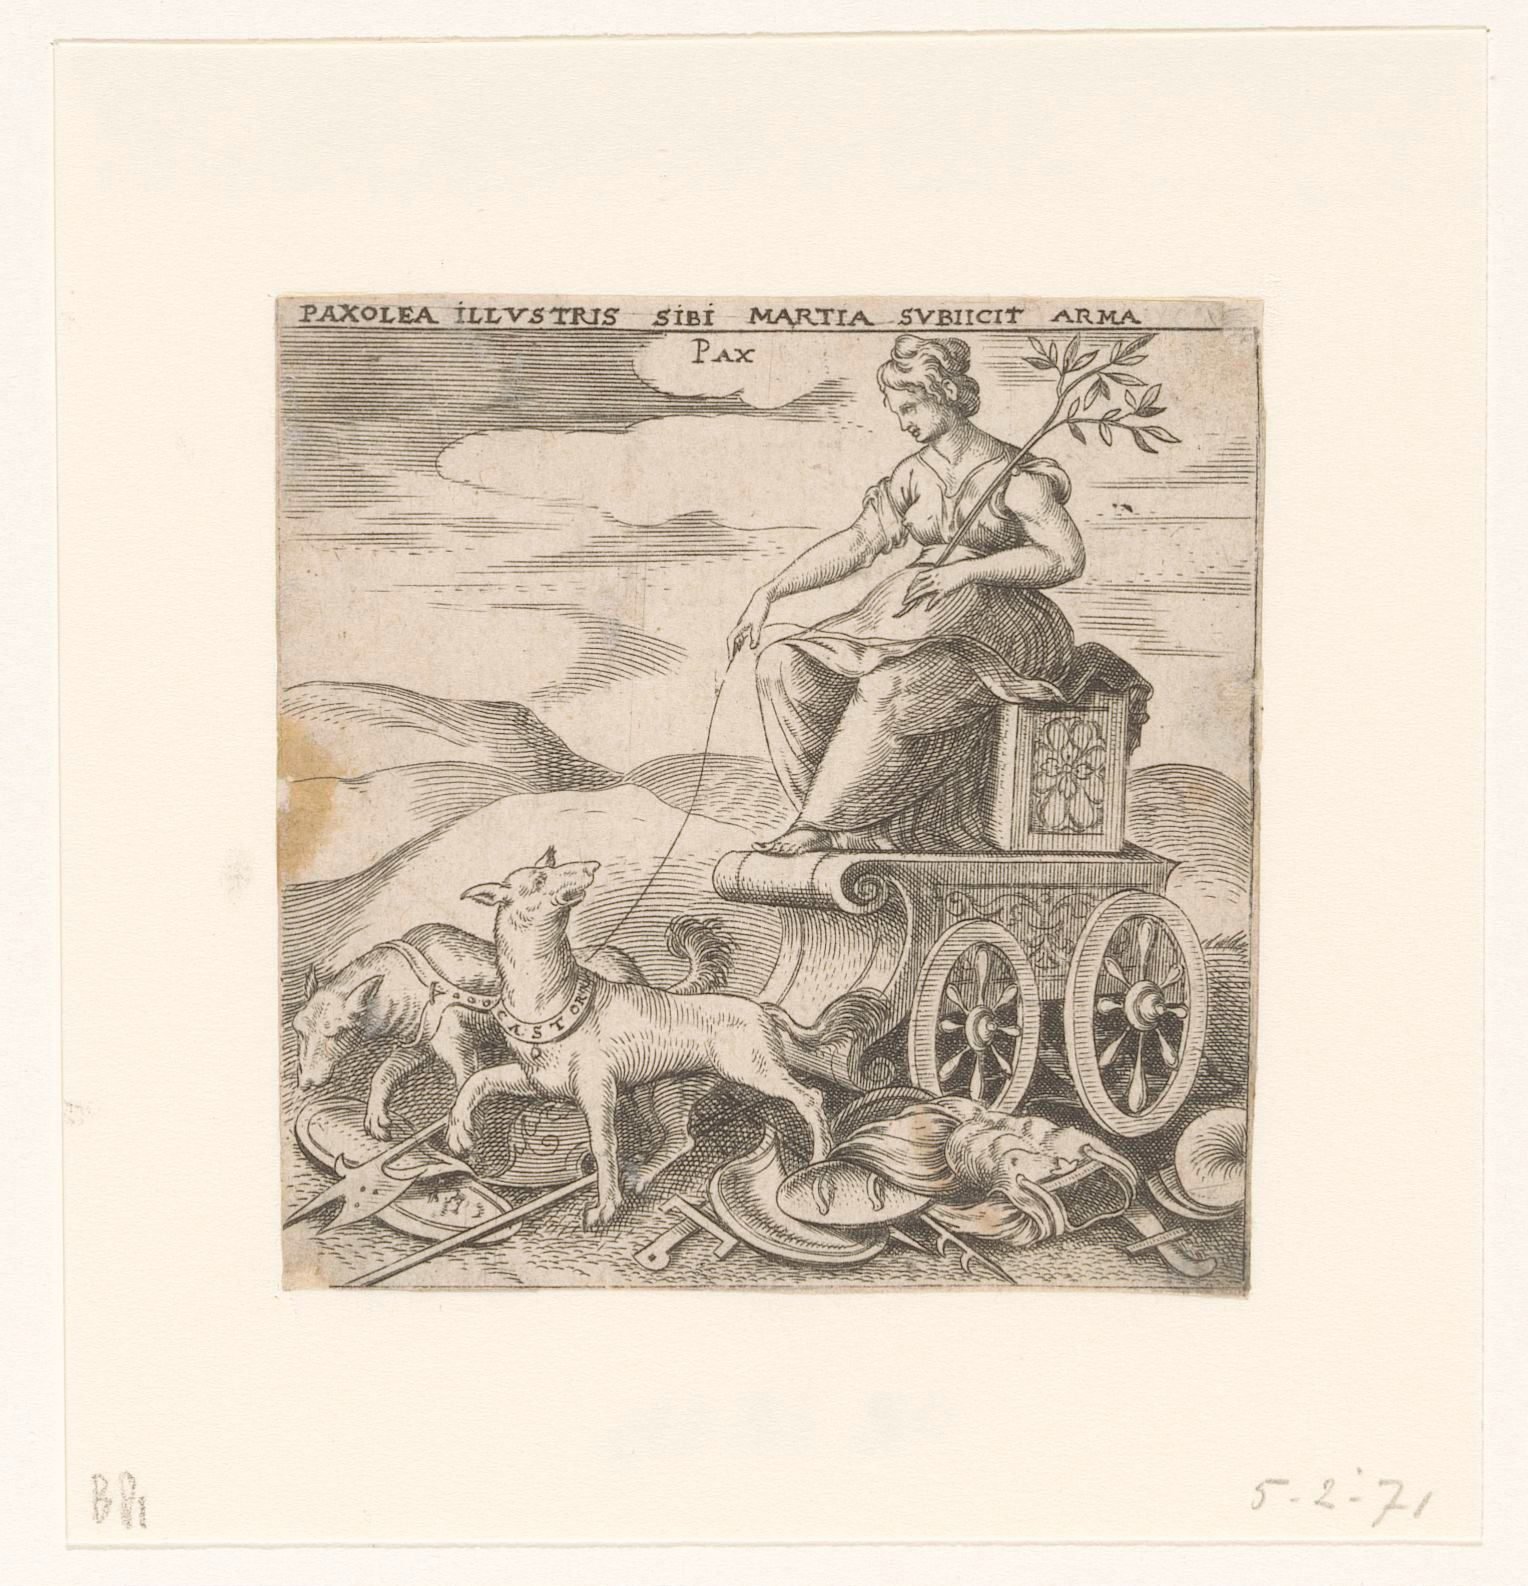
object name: print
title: Vrede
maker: francesco salviati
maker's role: draughtsman, painter, print maker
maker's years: 1510-1563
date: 1533-1567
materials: paper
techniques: engraving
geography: italy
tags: symbols, allegories of peace, 'pax'; 'pace' (ripa)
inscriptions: collector's mark: Lugt 240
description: Vrede (Pax) als vrouw zittend op een triomfwagen die getrokken wordt door twee honden. In haar hand houdt zij een olijftak. Op de grond liggen wapens waar de wagen overheen rijdt. Bovenaan een regel Latijnse tekst.